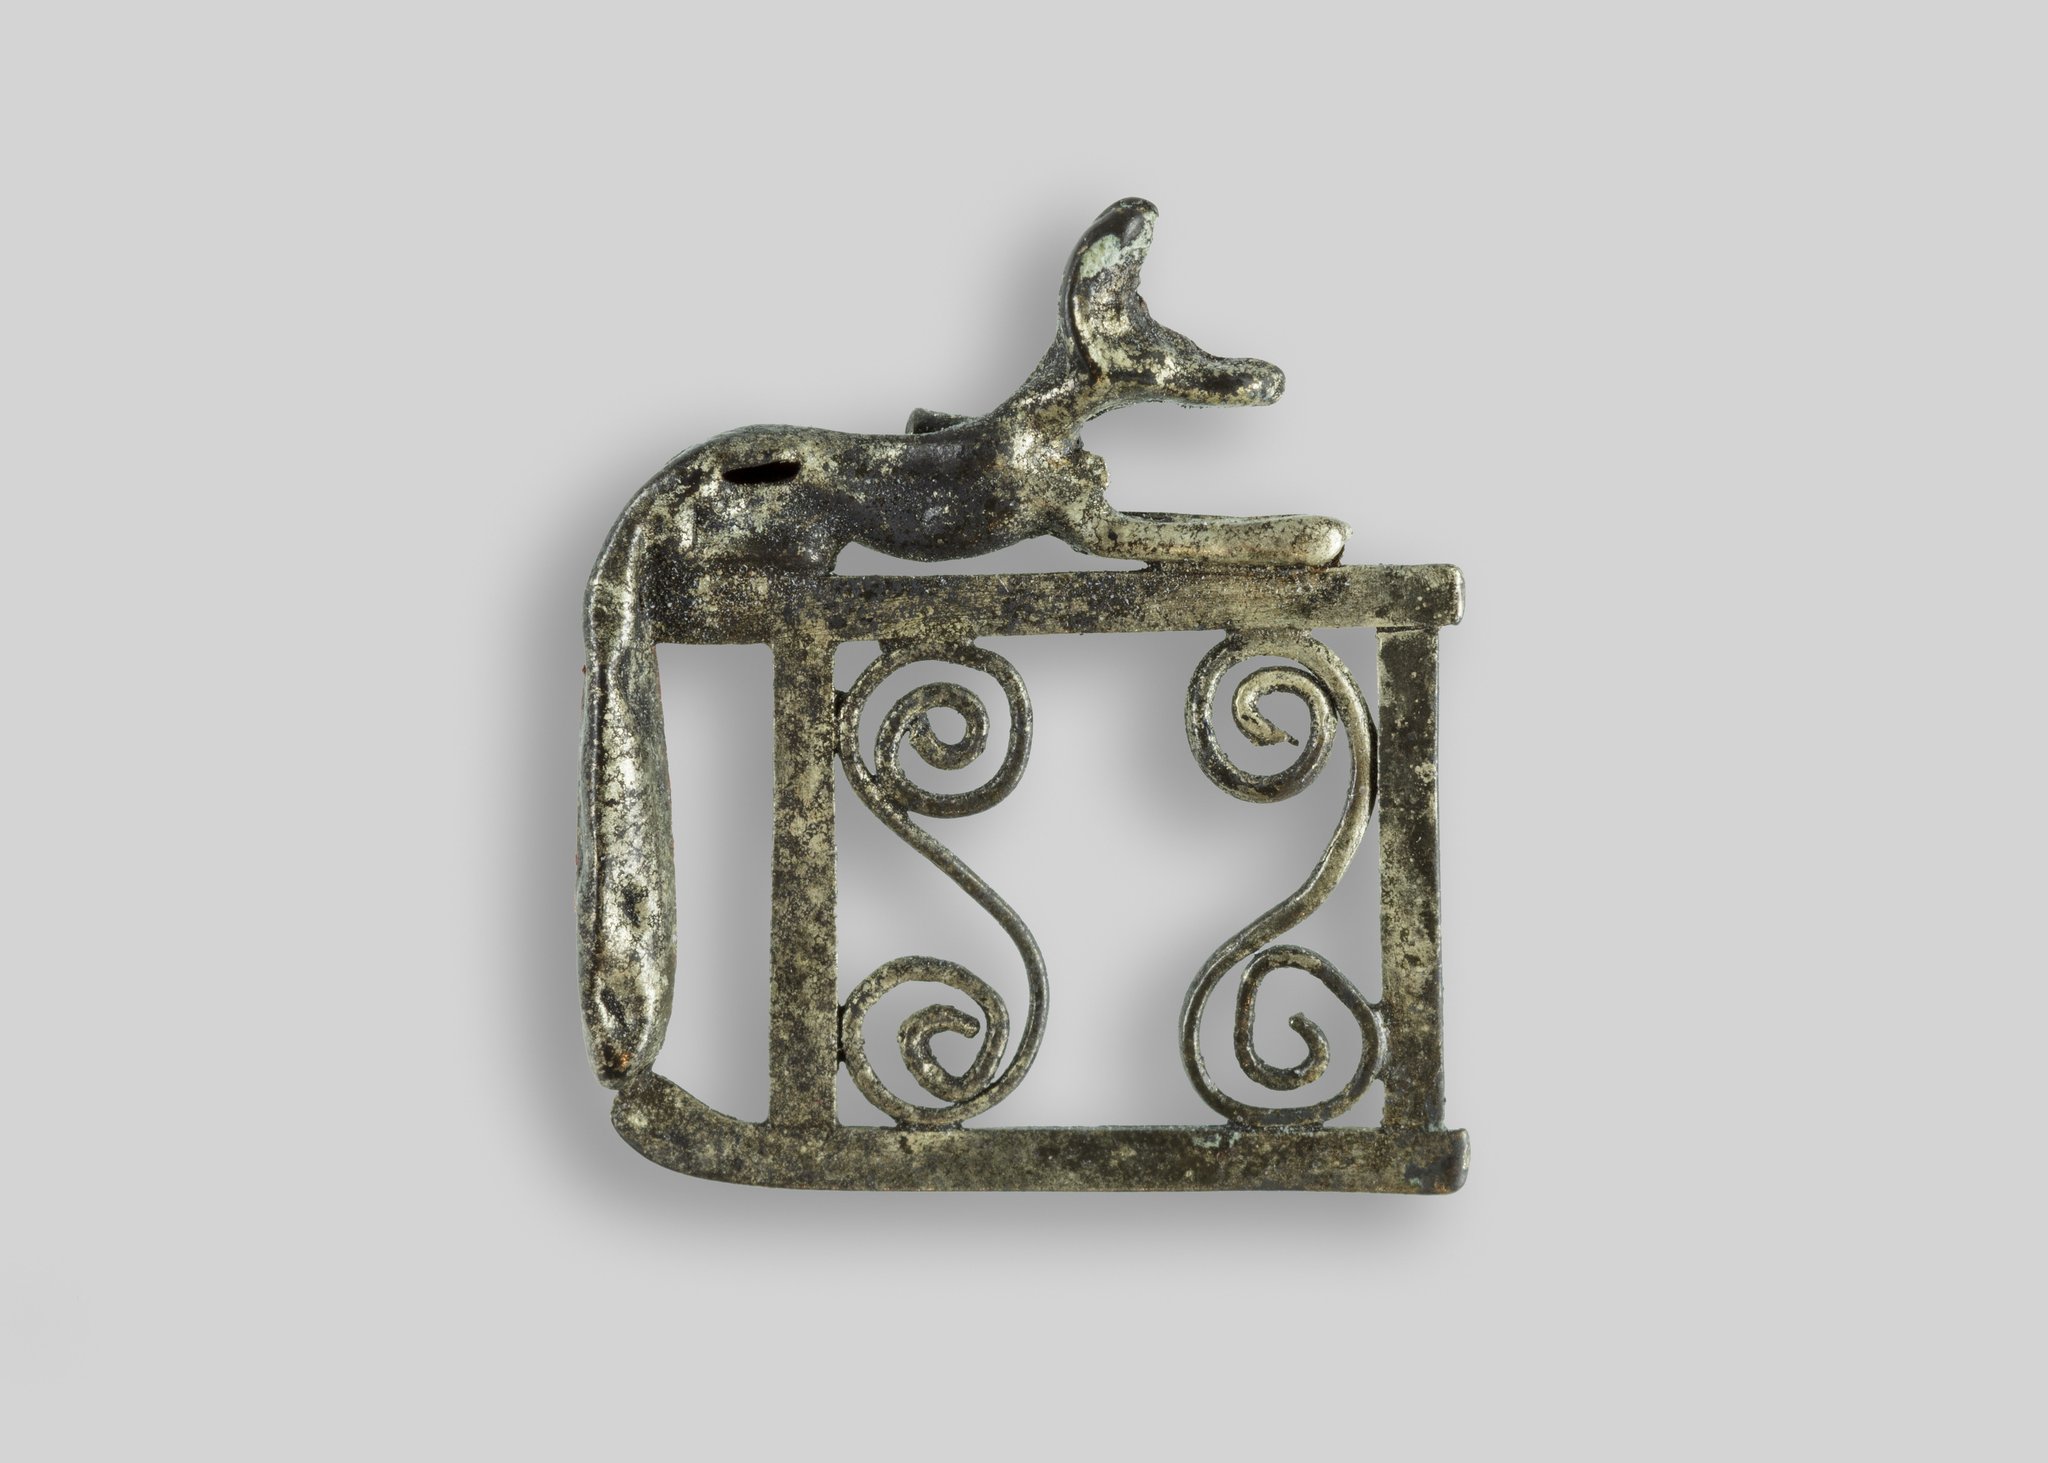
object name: amulet, anubis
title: Amulet of Anubis on his Shrine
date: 1850-1775 BCE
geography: egypt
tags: anubis